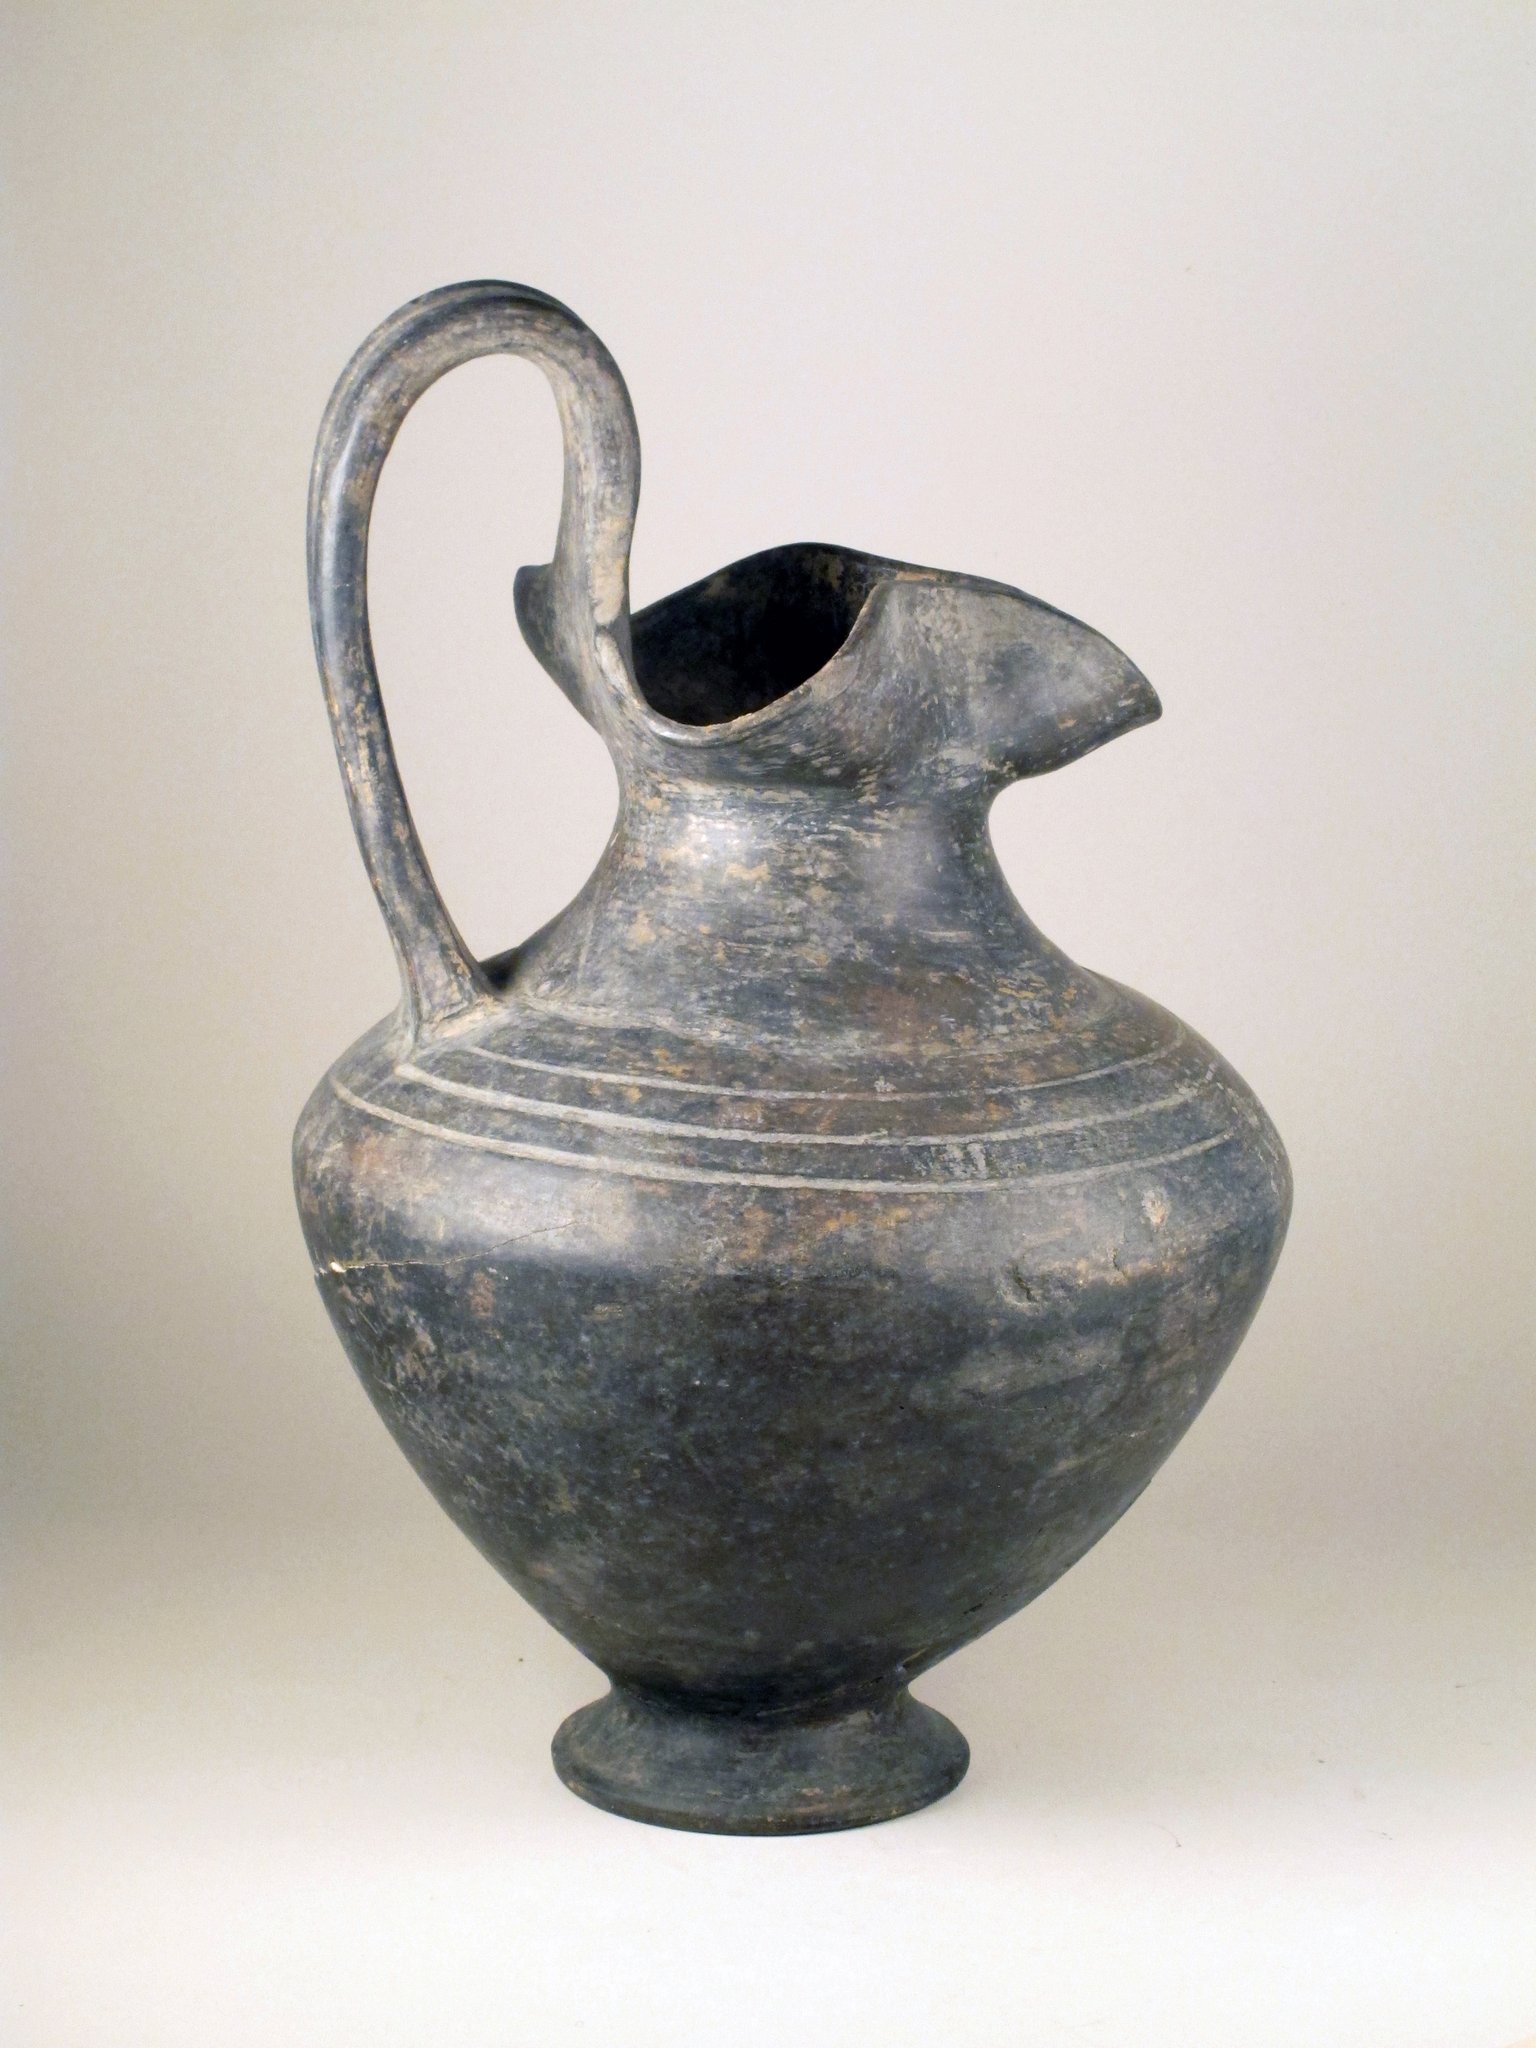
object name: oinochoe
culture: etruscan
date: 650-626 BCE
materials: terracotta